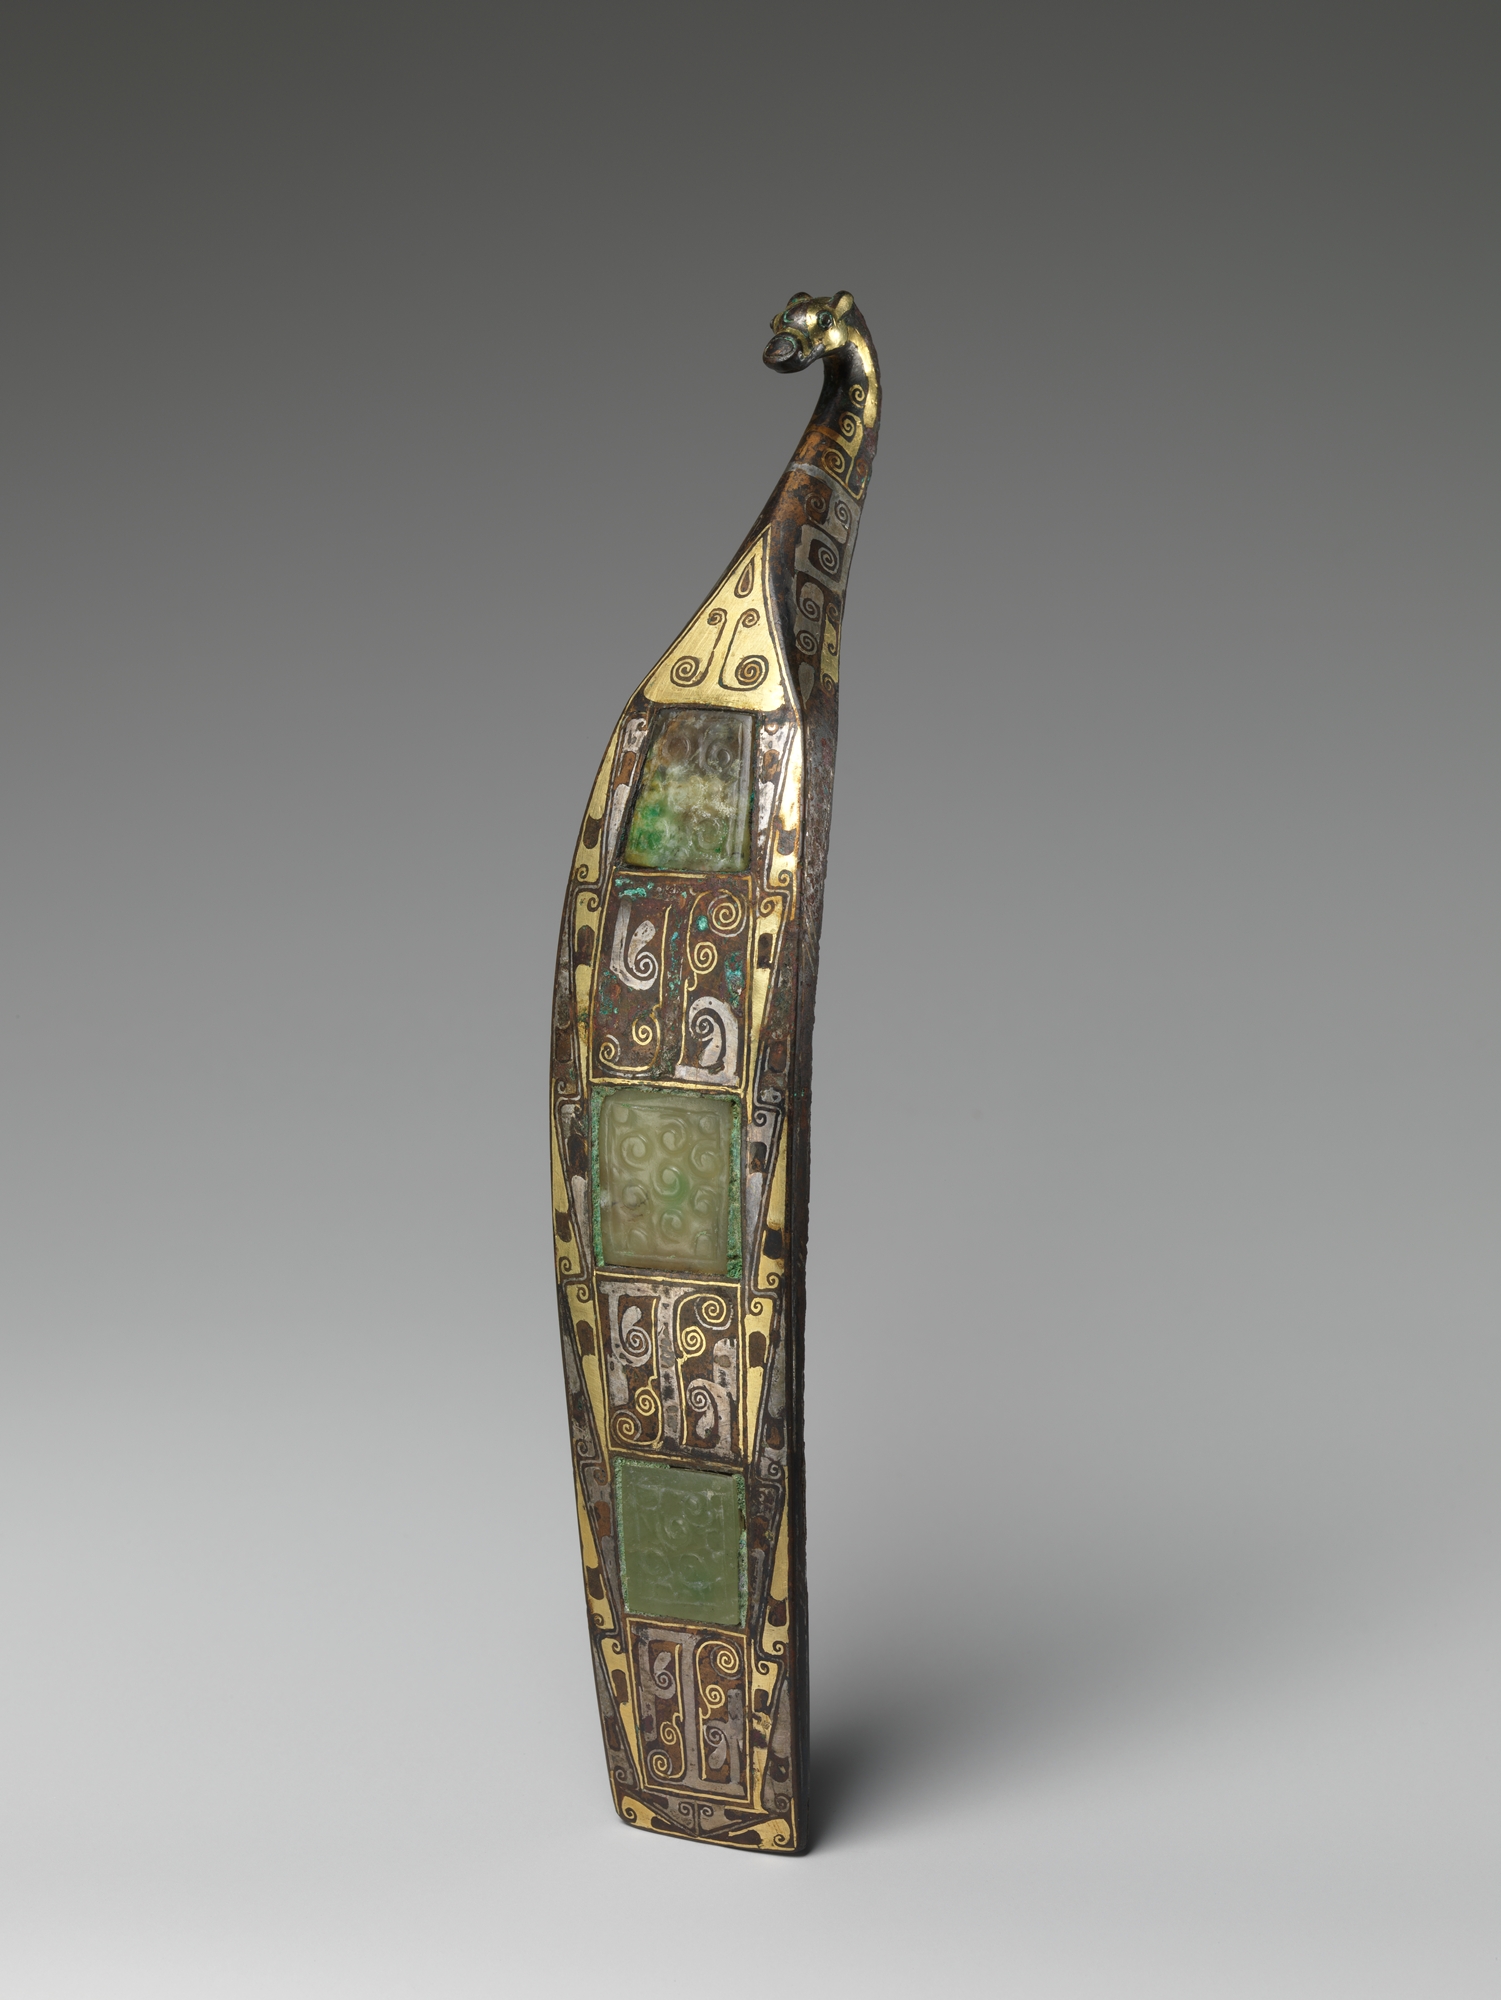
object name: belt hook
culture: chinese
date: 400-201 BCE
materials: bronze, gold, jade, silver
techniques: inlay